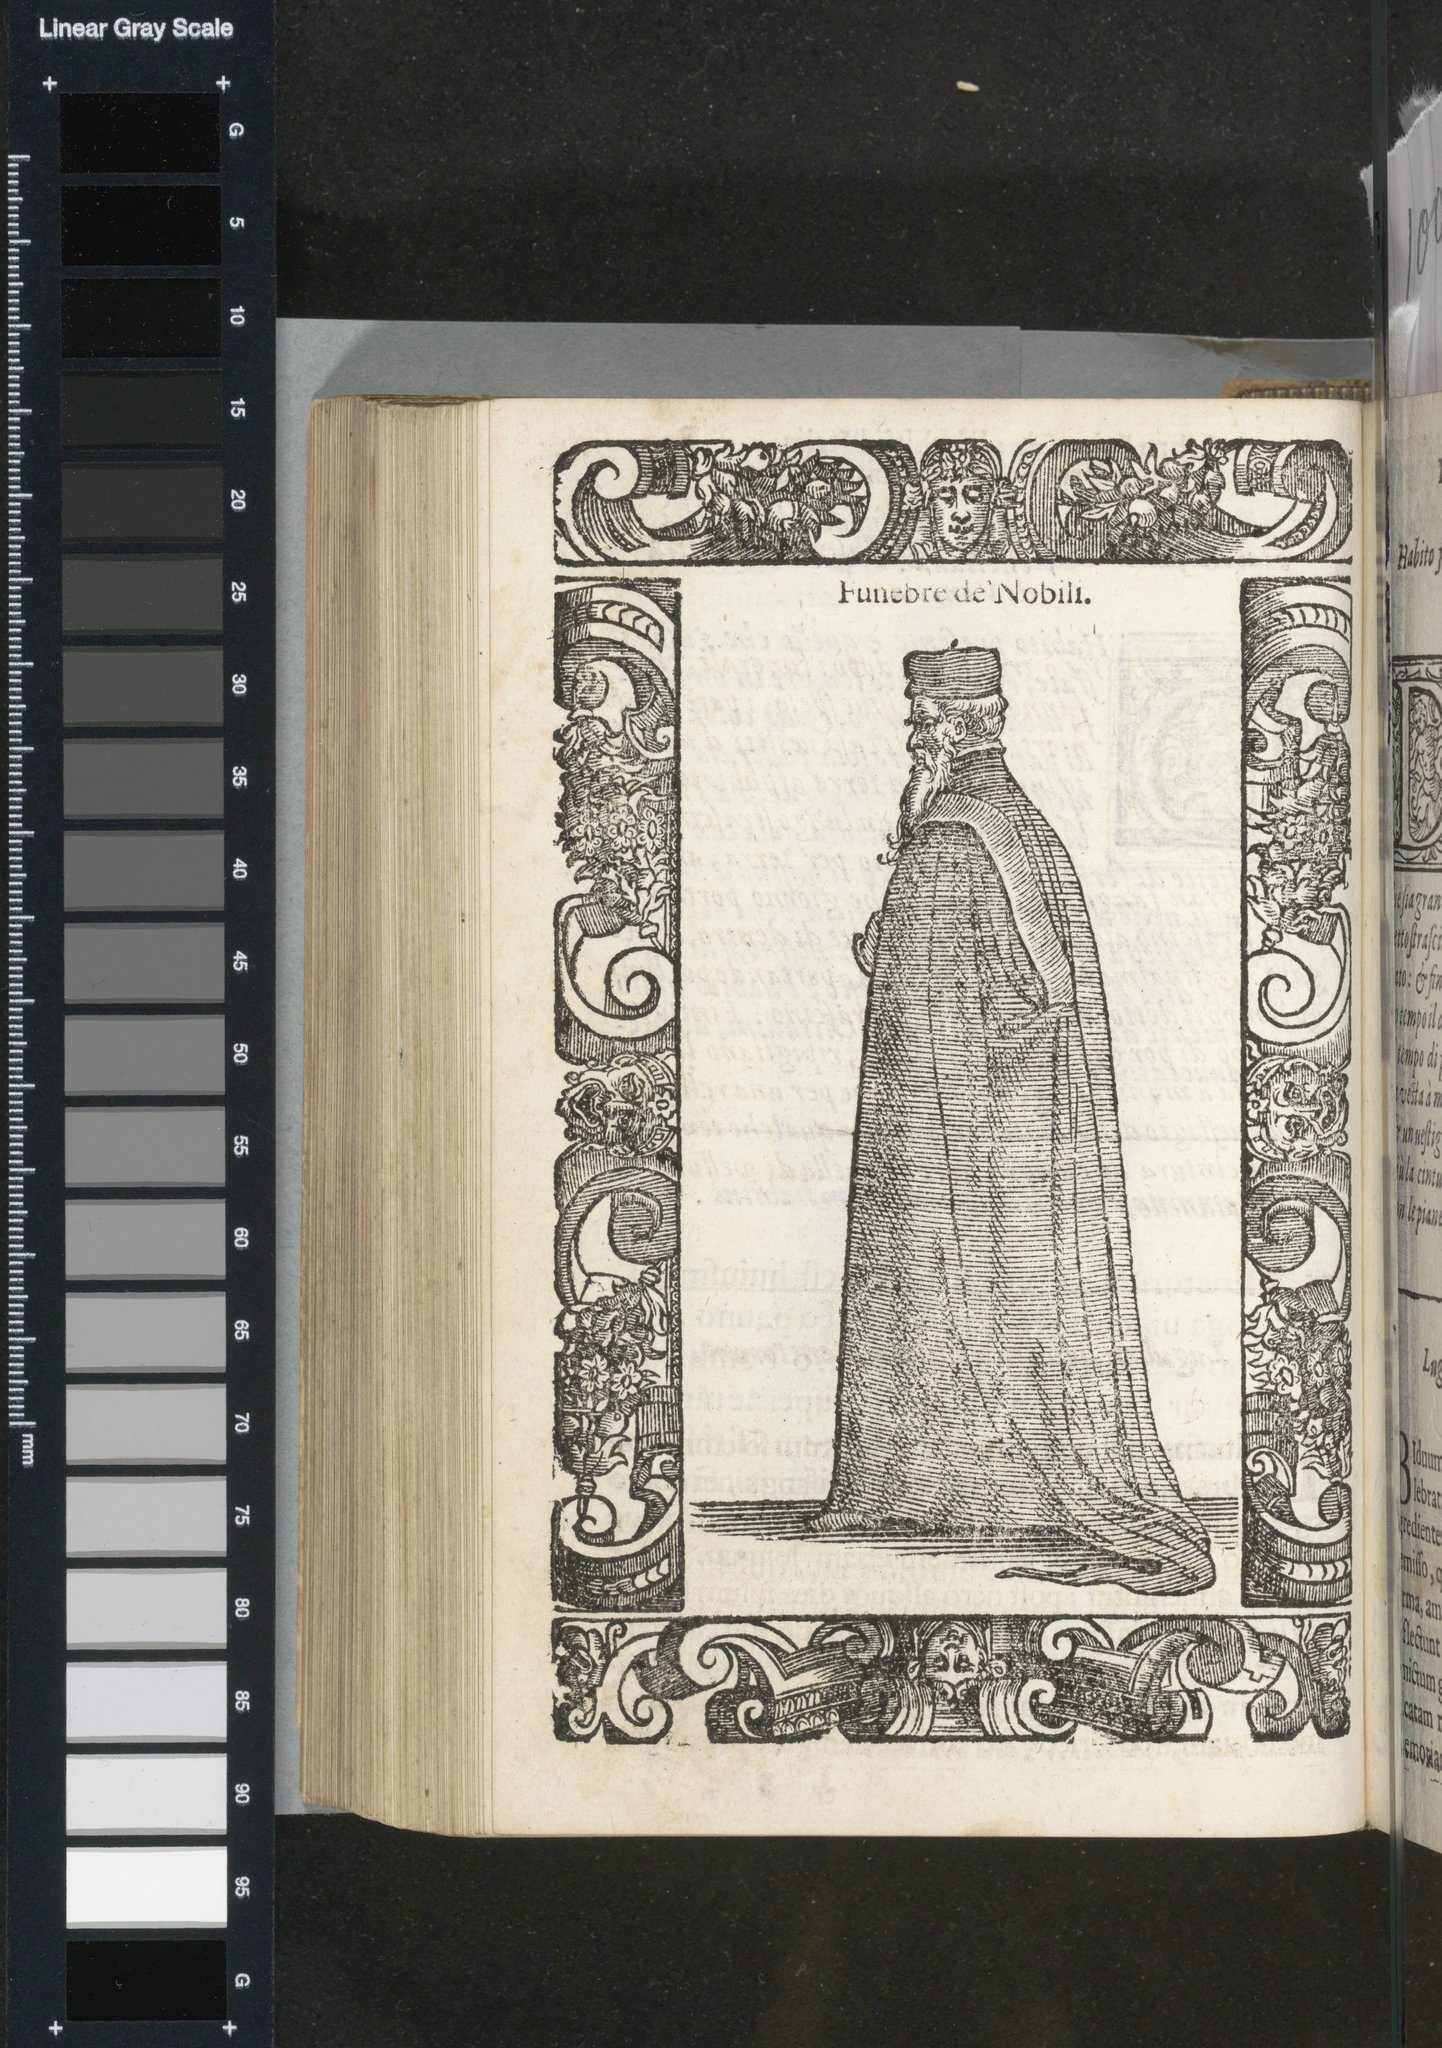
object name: costume print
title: Habiti antichi, et moderni di tutto il mondo..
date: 1598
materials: paper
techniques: woodcut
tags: fashion plates